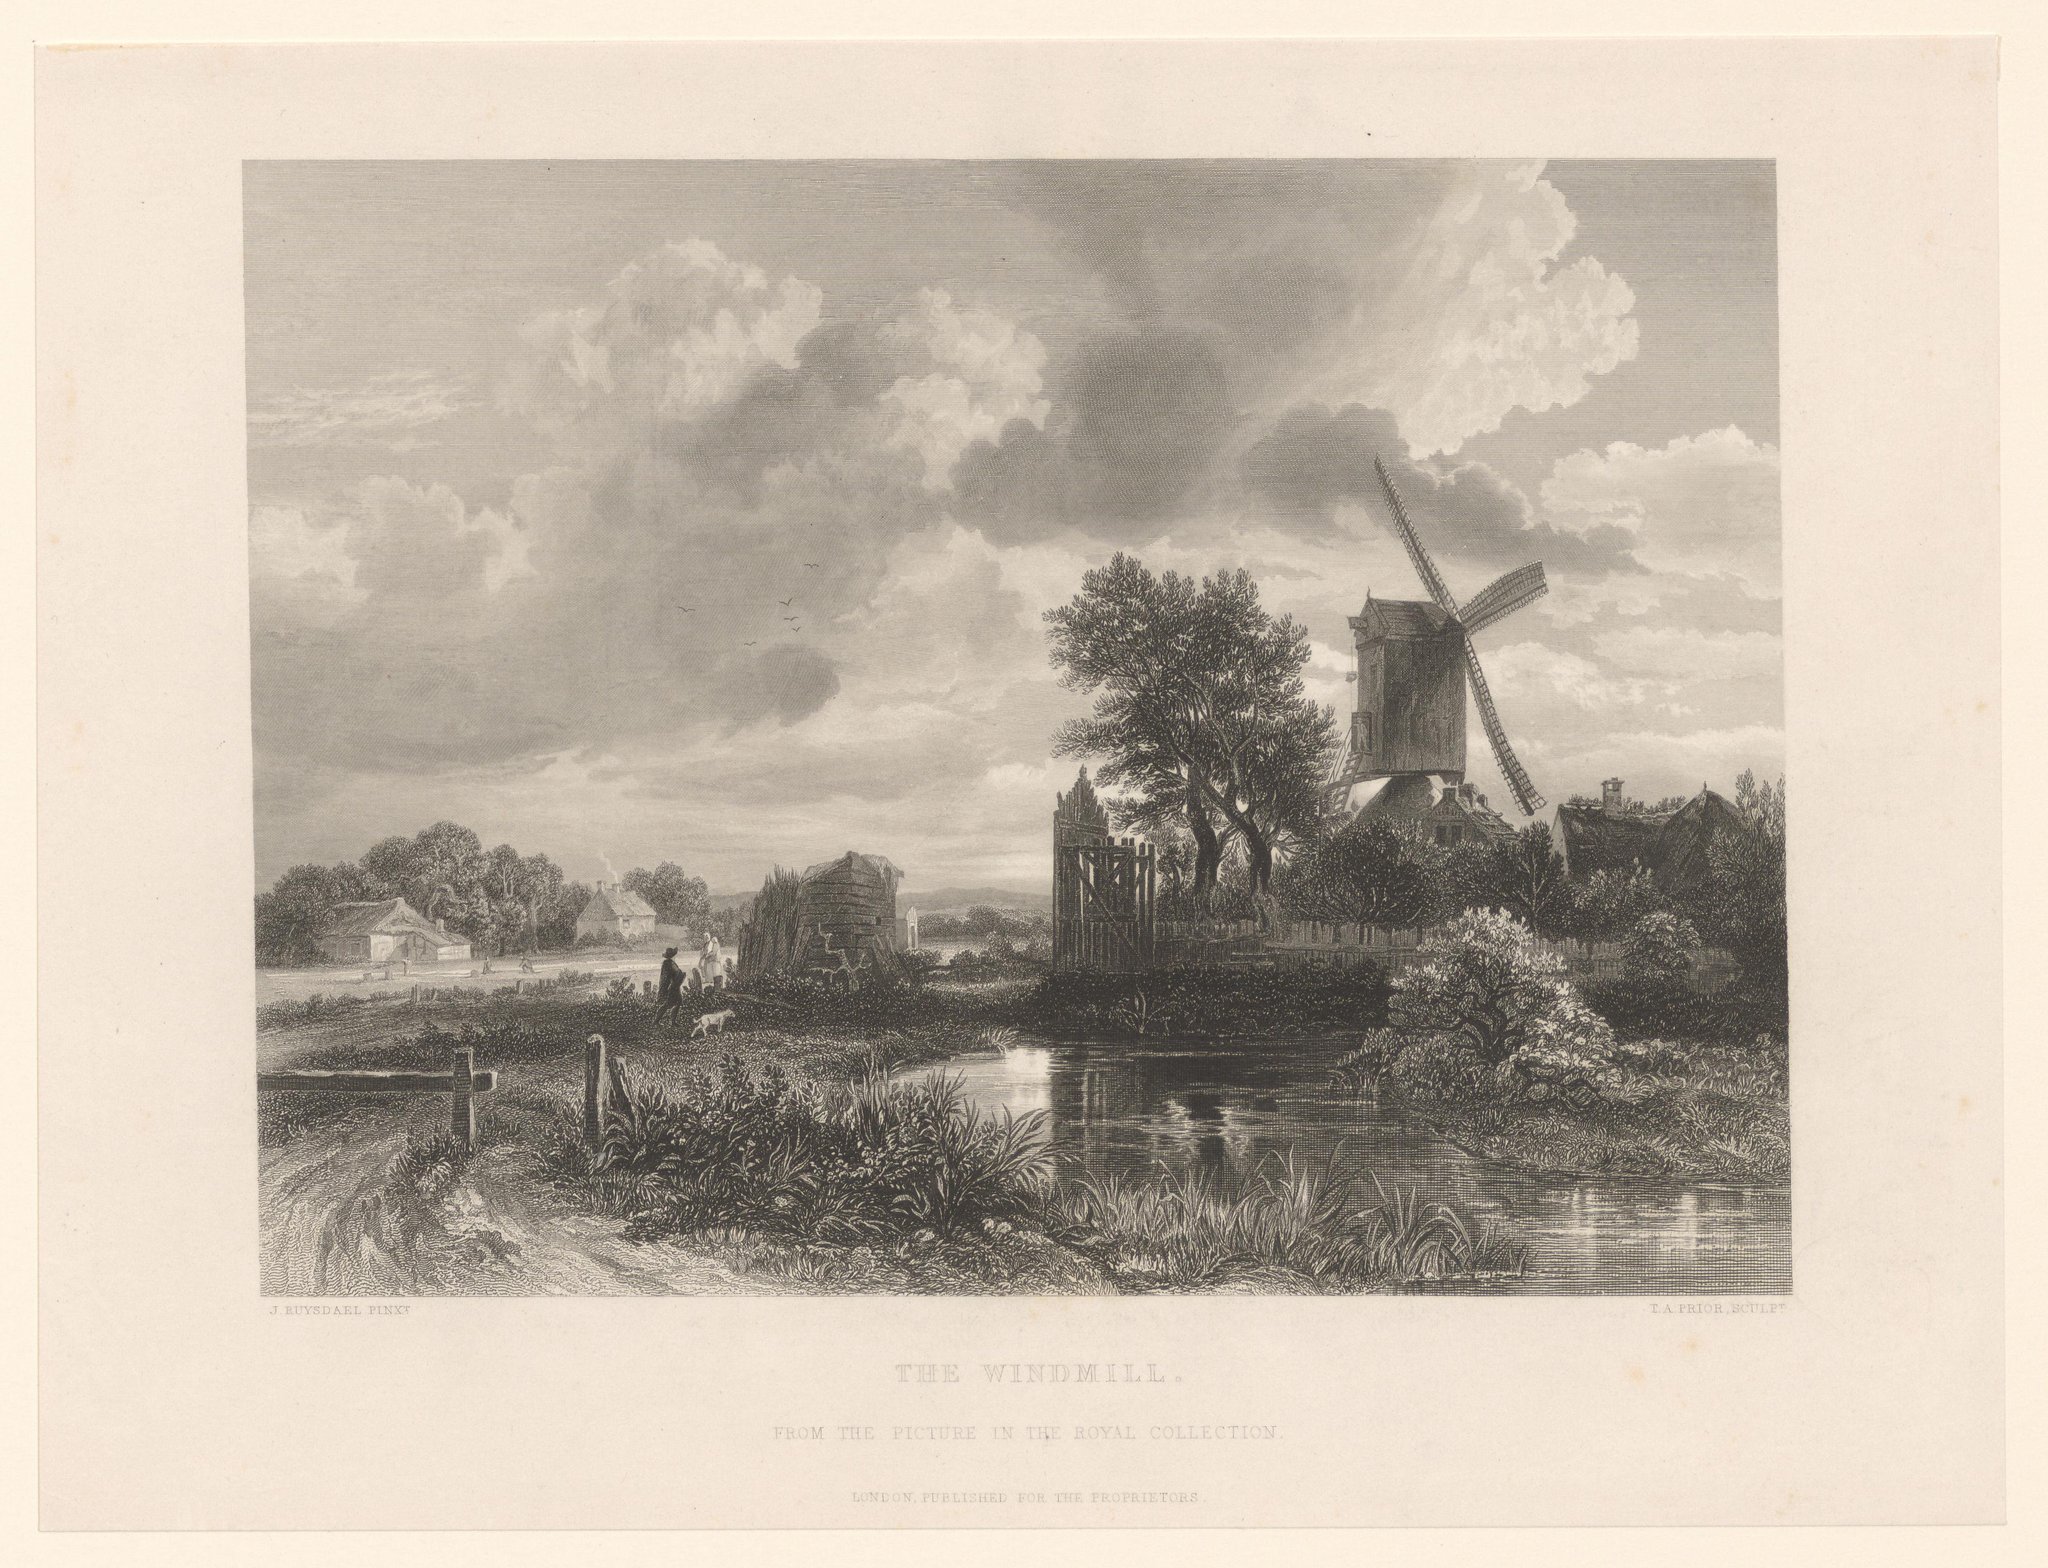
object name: print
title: Landschap met windmolen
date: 1819-1886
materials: paper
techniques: engraving, etching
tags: windmill in landscape (+ city(-scape) with figures, staffage)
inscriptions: collector's mark: Lugt 2228